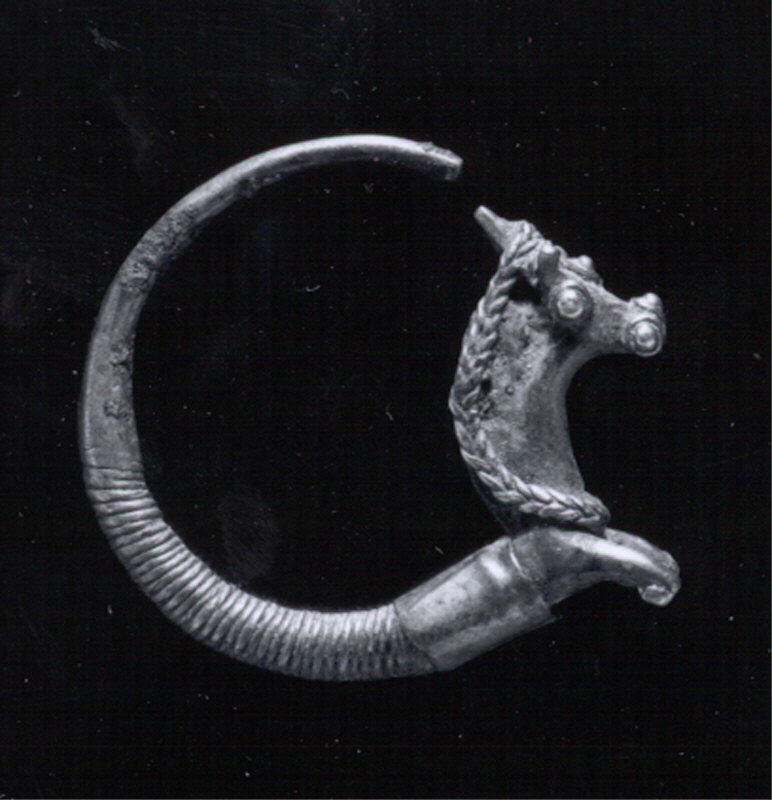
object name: earring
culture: parthian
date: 300-101 BCE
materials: silver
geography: iran (?)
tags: animals